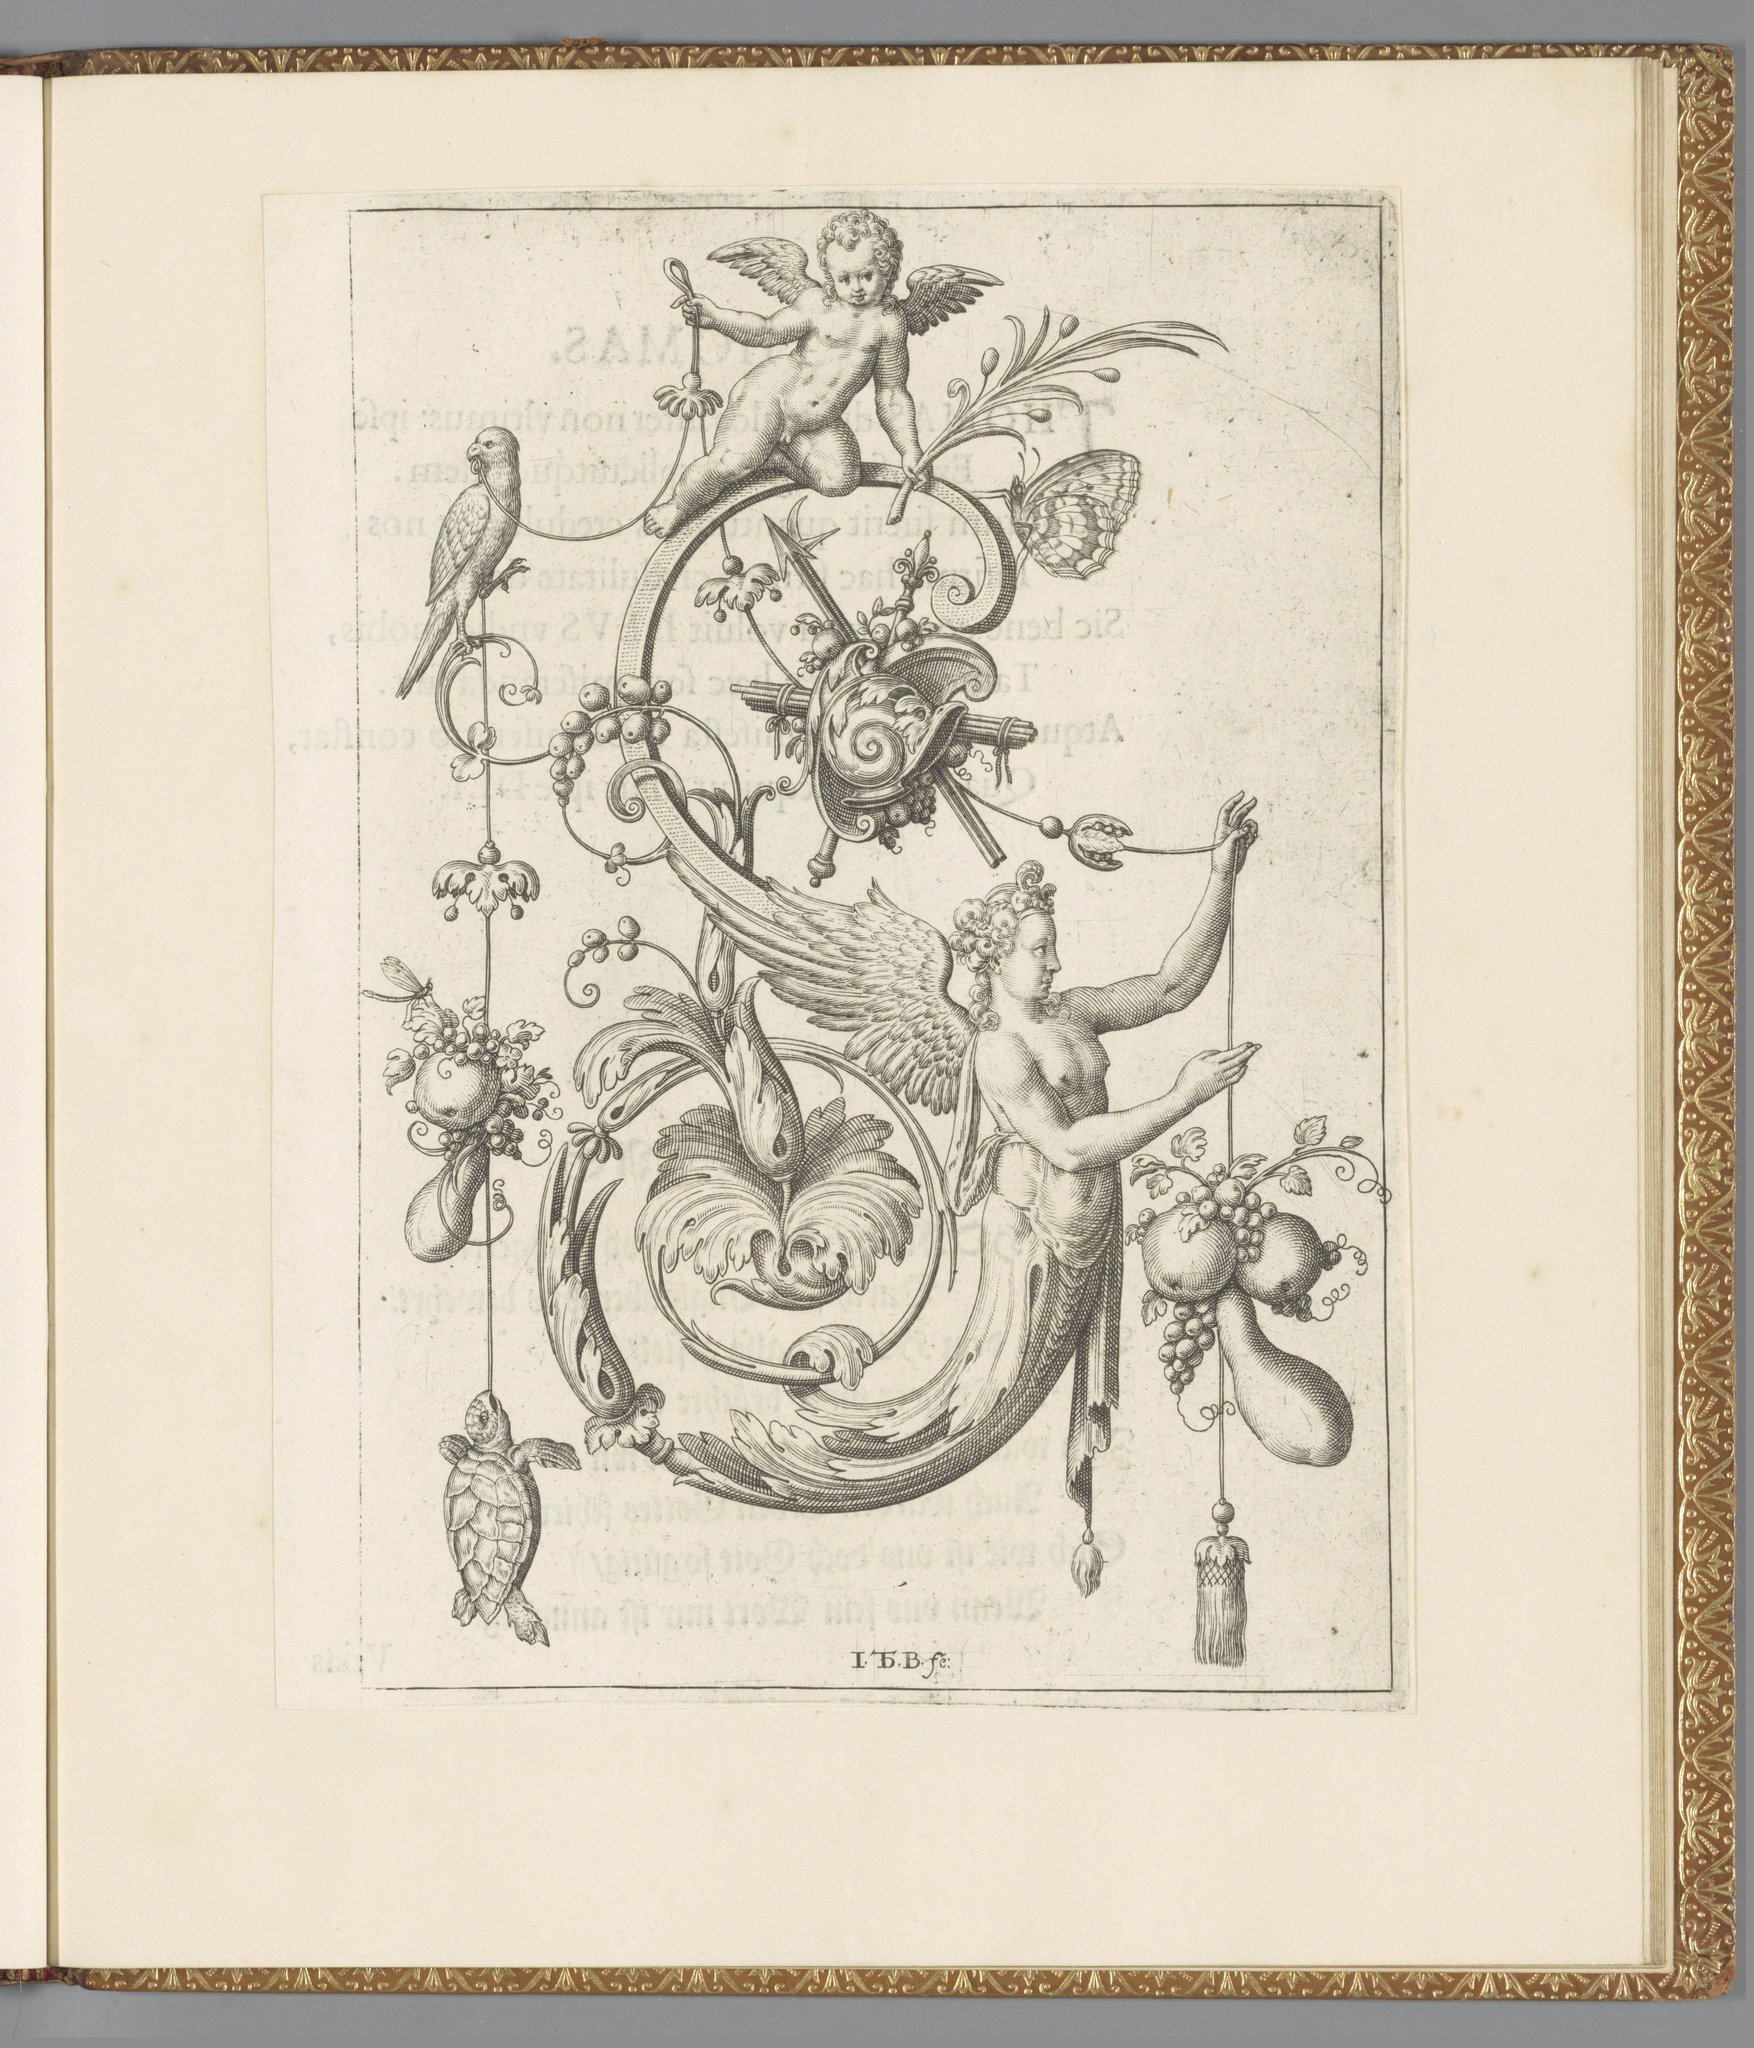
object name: ornament print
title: Letter S van Salomo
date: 1595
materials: paper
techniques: engraving, letterpress printing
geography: frankfurt am main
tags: tortoises, turtles, ornament ~ human parts, letters, alphabet, script, foliage, tendrils, branches ~ ornament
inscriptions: collector's mark: Lugt 2228, collector's mark: Lugt 2760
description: Ornamentele letter S van Salomo. De letter wordt onderaan gevormd door bladranken en een vrouwelijke halffiguur met vleugels. Midden boven een putto met vleugels. De letter is verder versierd met een vlinder, papegaai, trossen vruchten en een schildpad. Op verso verzen in het Latijn en het Duits. Prent maakt deel uit van een album.